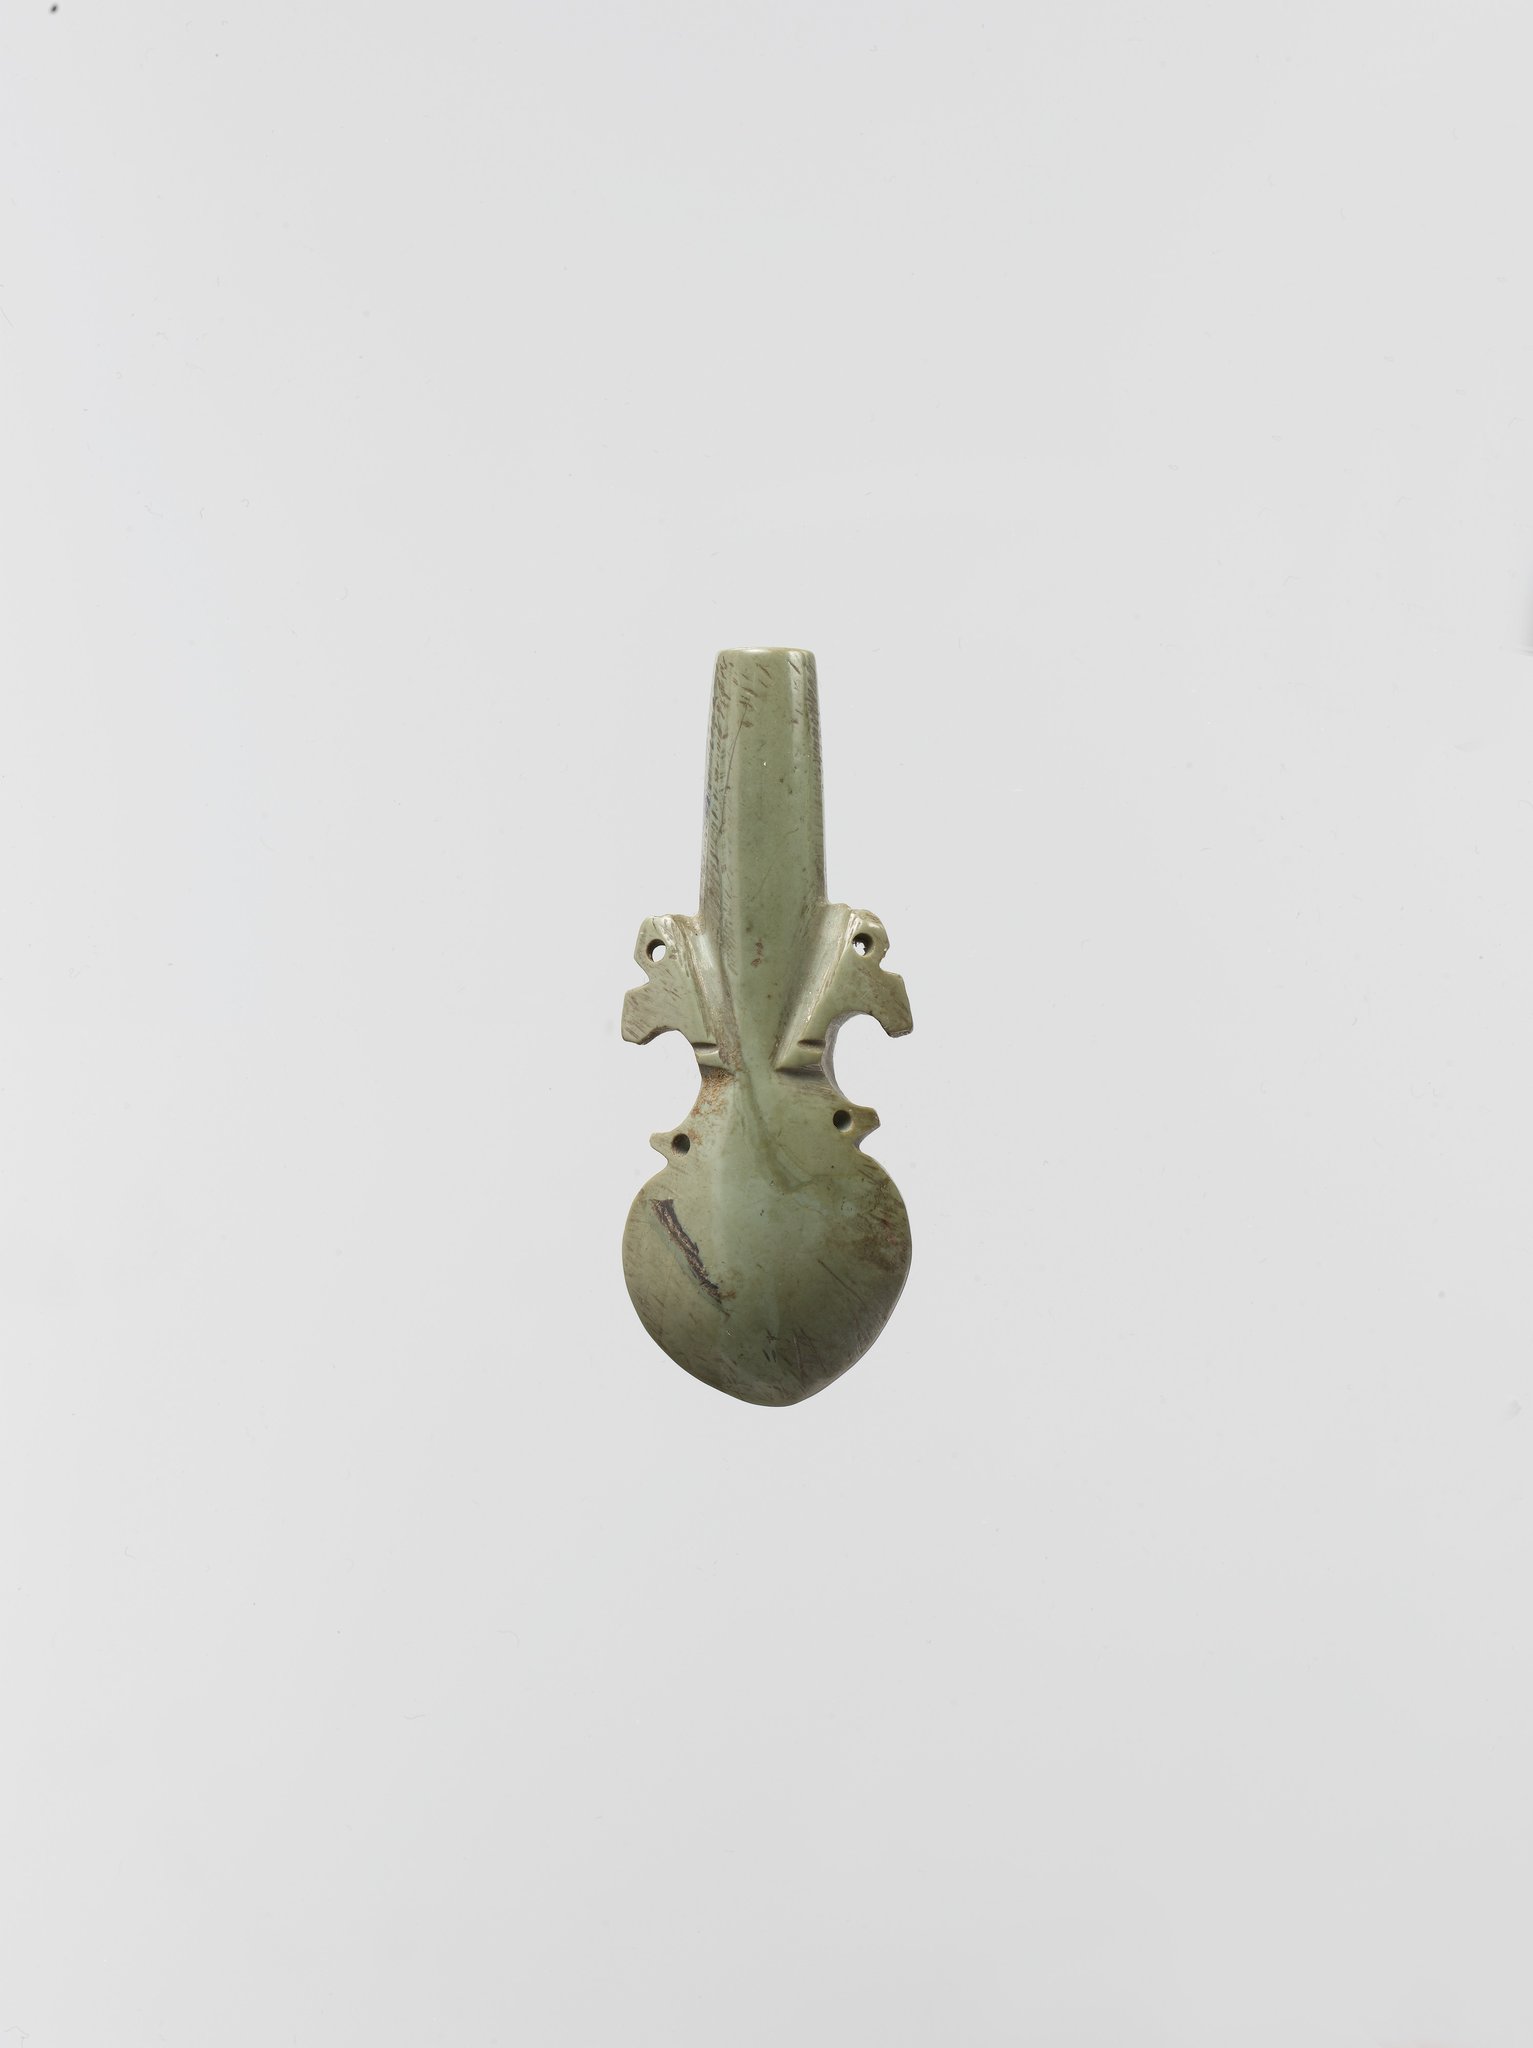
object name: kohl flask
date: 901-1200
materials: stone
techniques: carving, incising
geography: iran